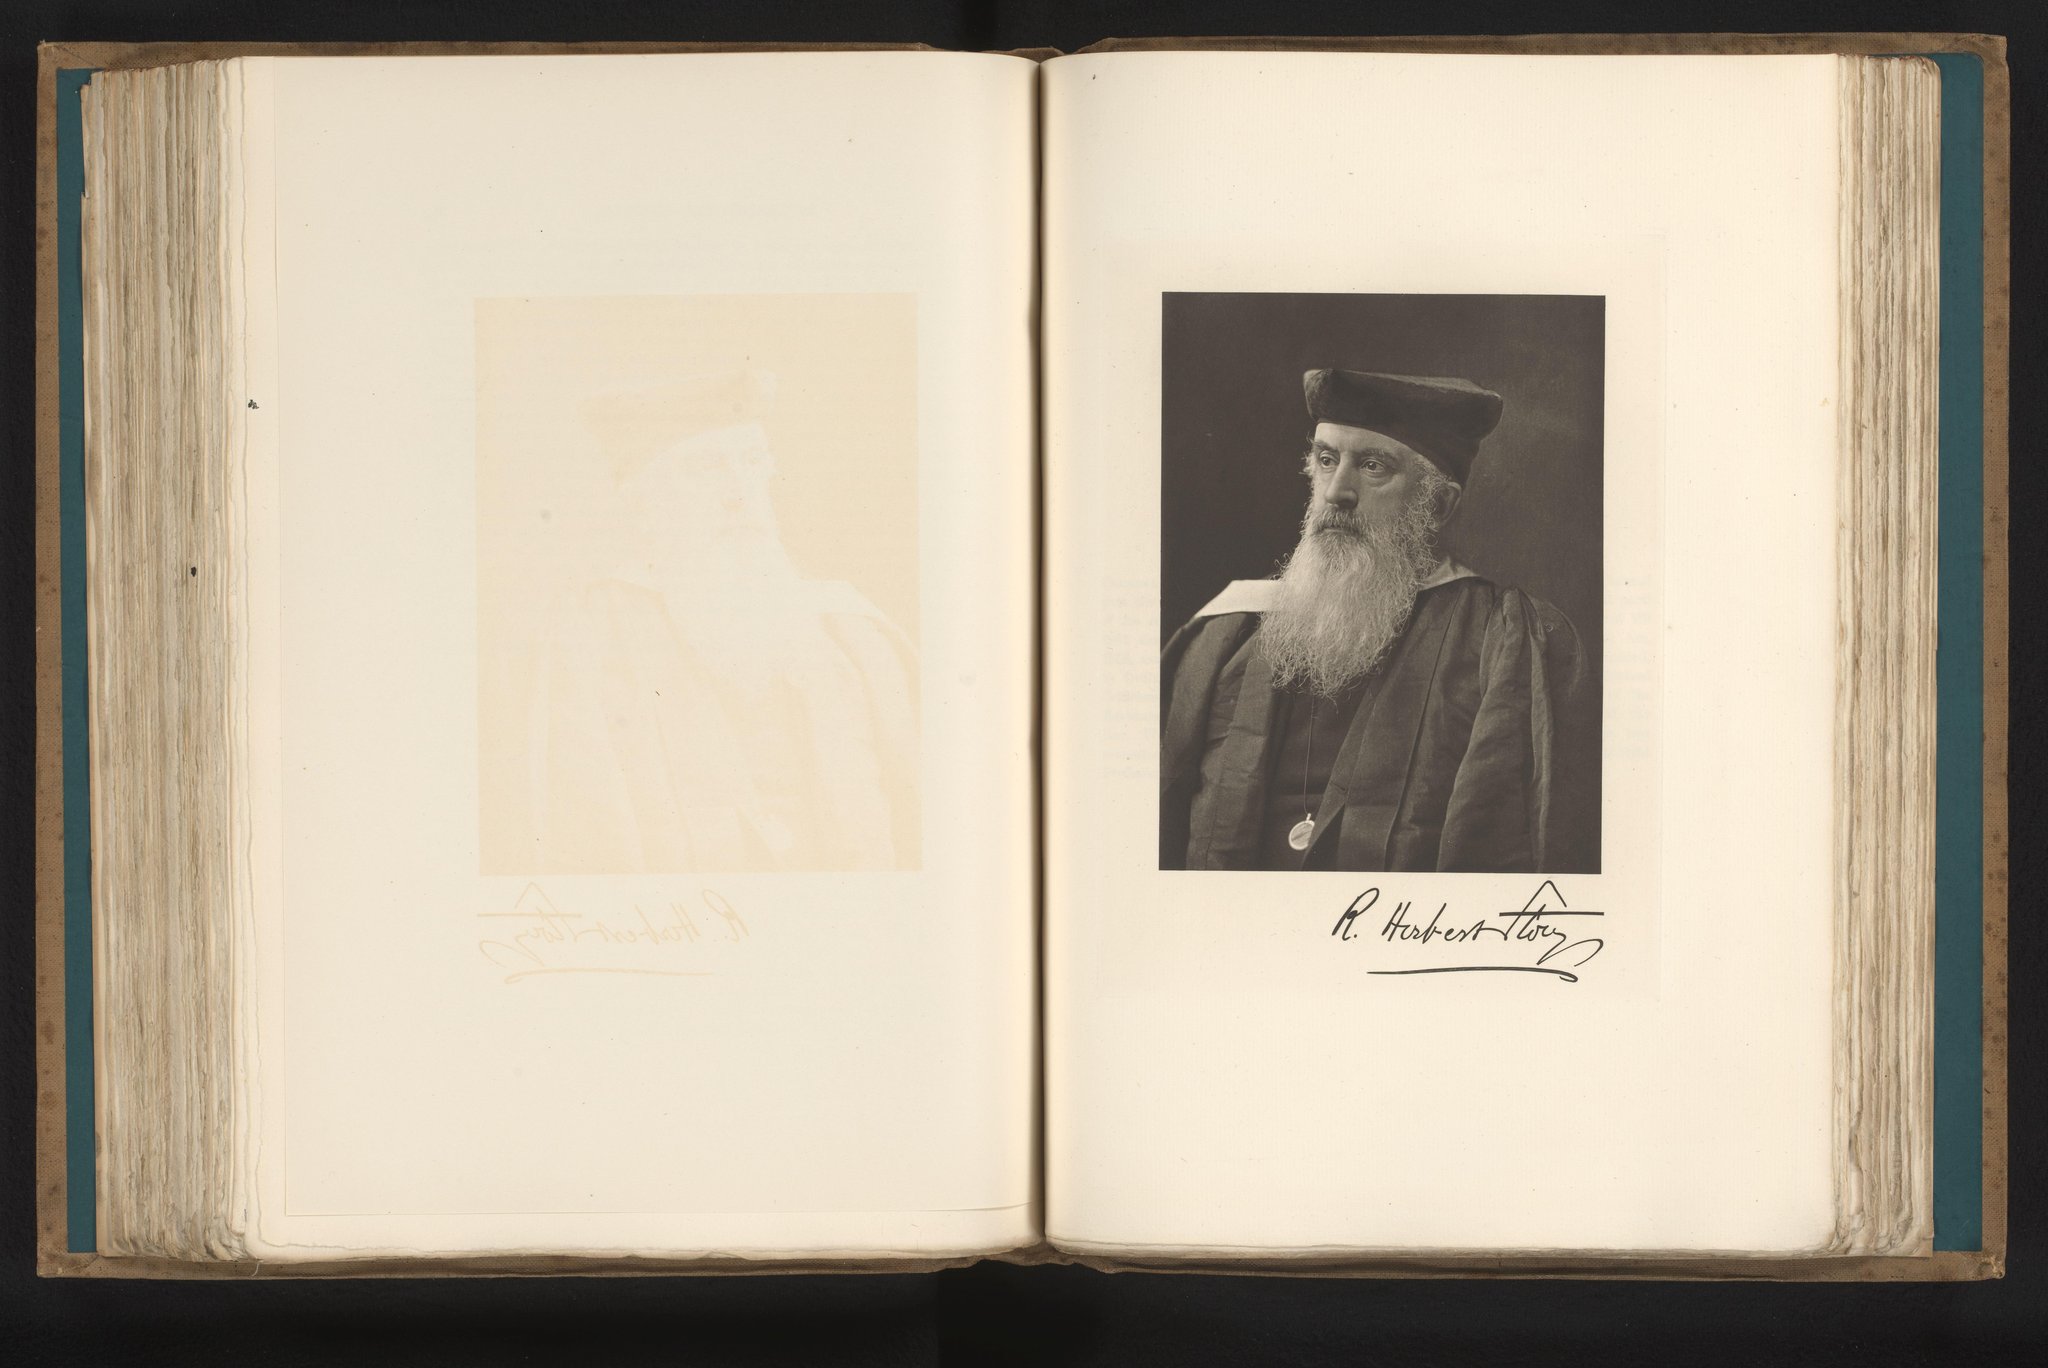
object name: page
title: Portret van Robert Herbert Story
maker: Anonymous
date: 1886-1891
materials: paper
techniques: photoaquatint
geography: glasgow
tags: historical persons, aspects of science in general (+ portrait of scholar, scientist)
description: Prent op tweede ongenummerde pagina na pagina 91.